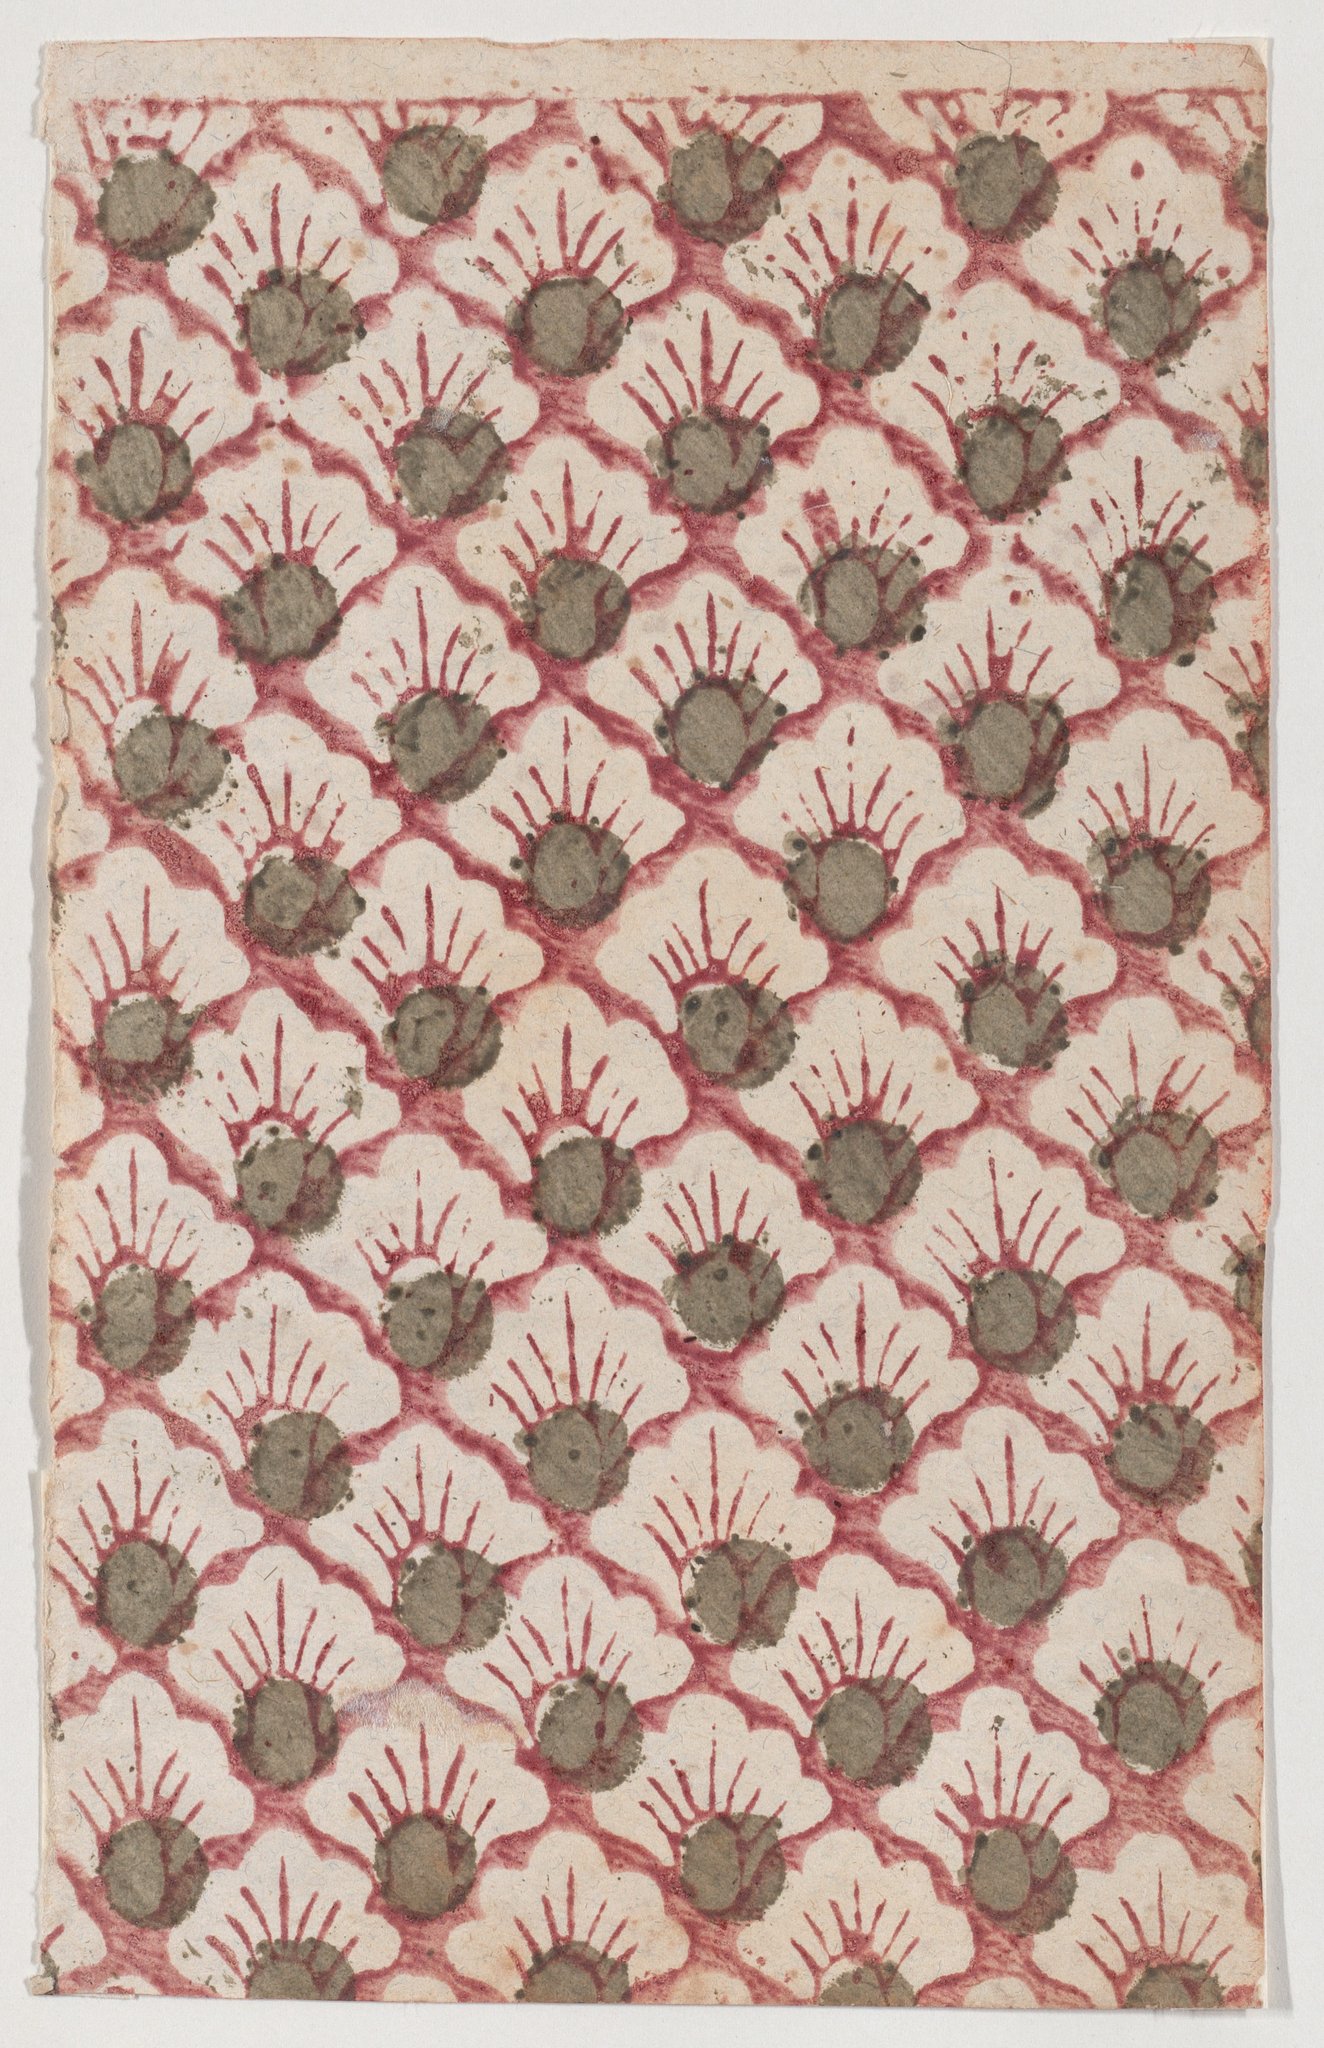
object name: print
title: Sheet with overall pattern of petals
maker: Anonymous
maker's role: artist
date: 1801-1900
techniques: relief print